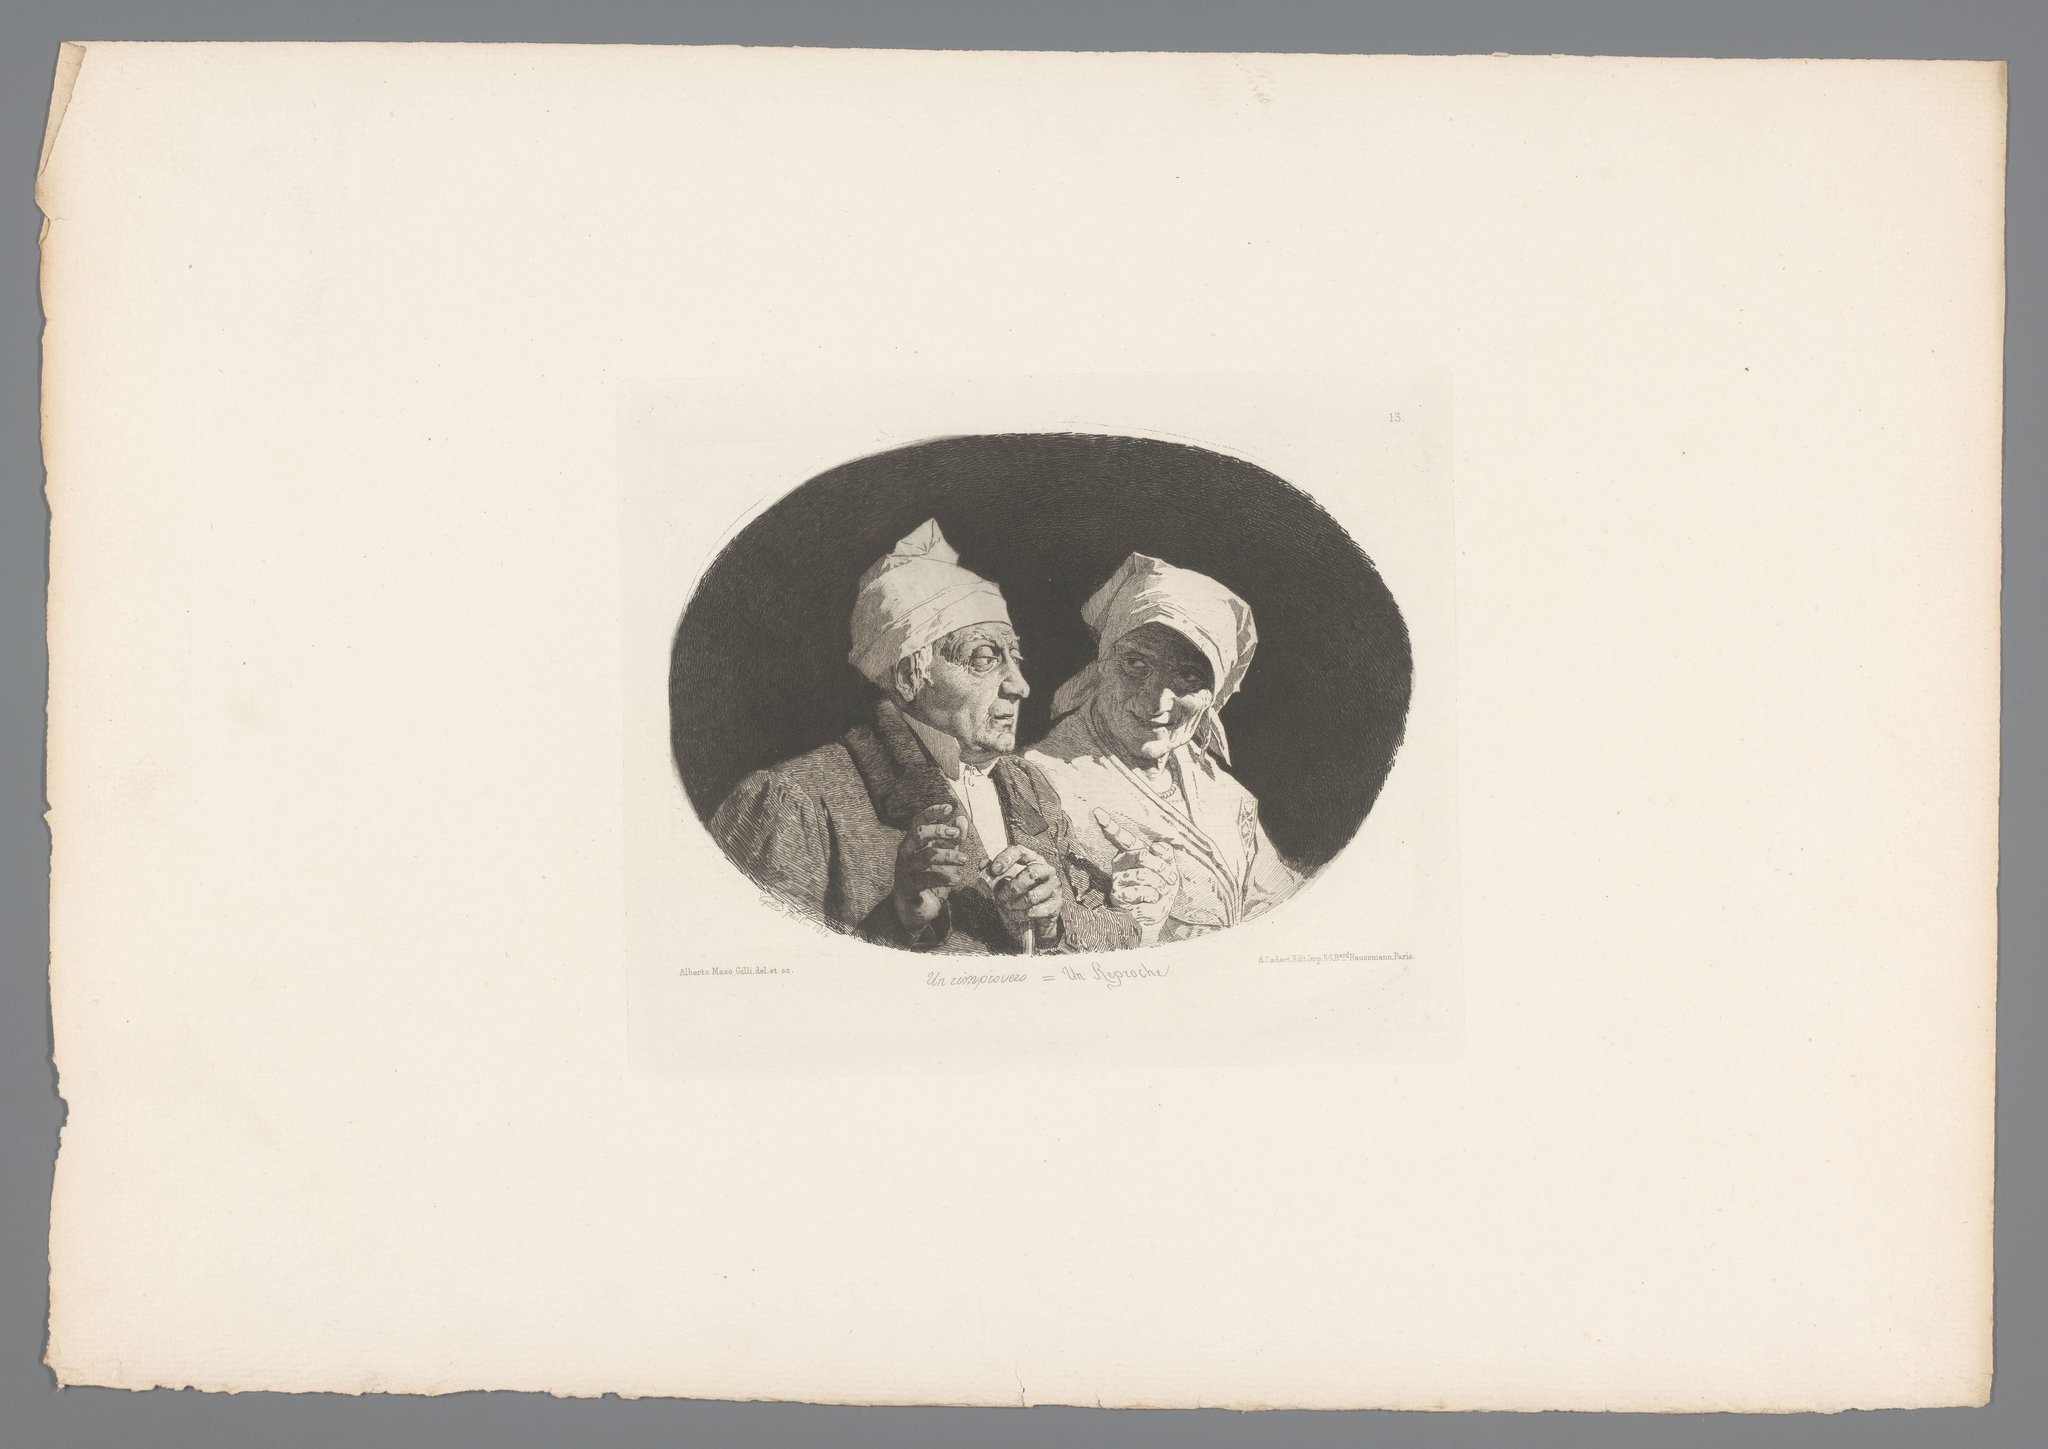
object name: print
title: L'eau-forte en 1875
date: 1875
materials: paper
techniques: drypoint, etching, intaglio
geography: paris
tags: old man, old woman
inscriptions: collector's mark: Lugt 2228, collector's mark: ‘AFE v S’, watermark, collector's mark: Lugt 2760